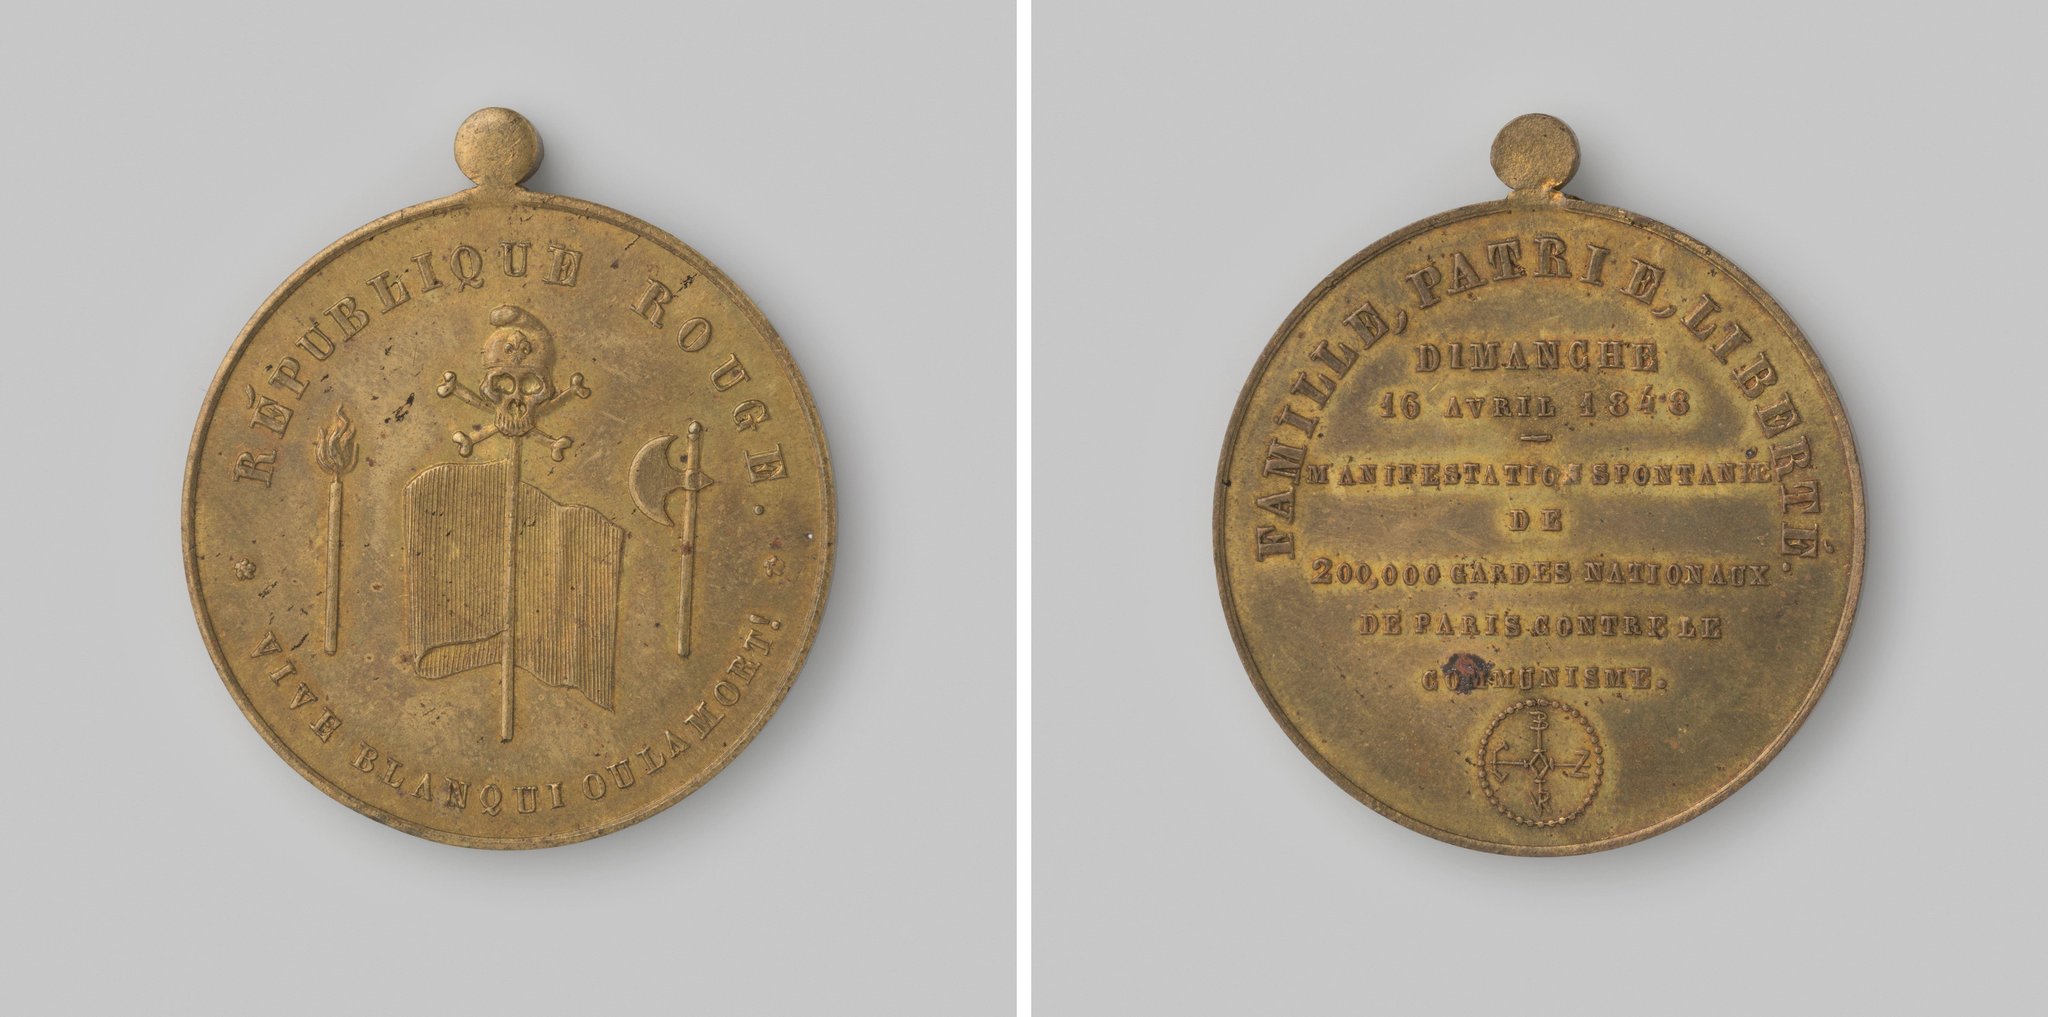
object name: history medal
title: Protest tegen het communisme 1848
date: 1848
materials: brass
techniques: striking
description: Messing penning met niet-doorbord draagoog, op de voorzijde een rode vlag waarop een doodshoofd tussen een toorts en een bijl, met omschrift, op de keerzijde acht regels tekst boven een monogram in een parelcirkel.